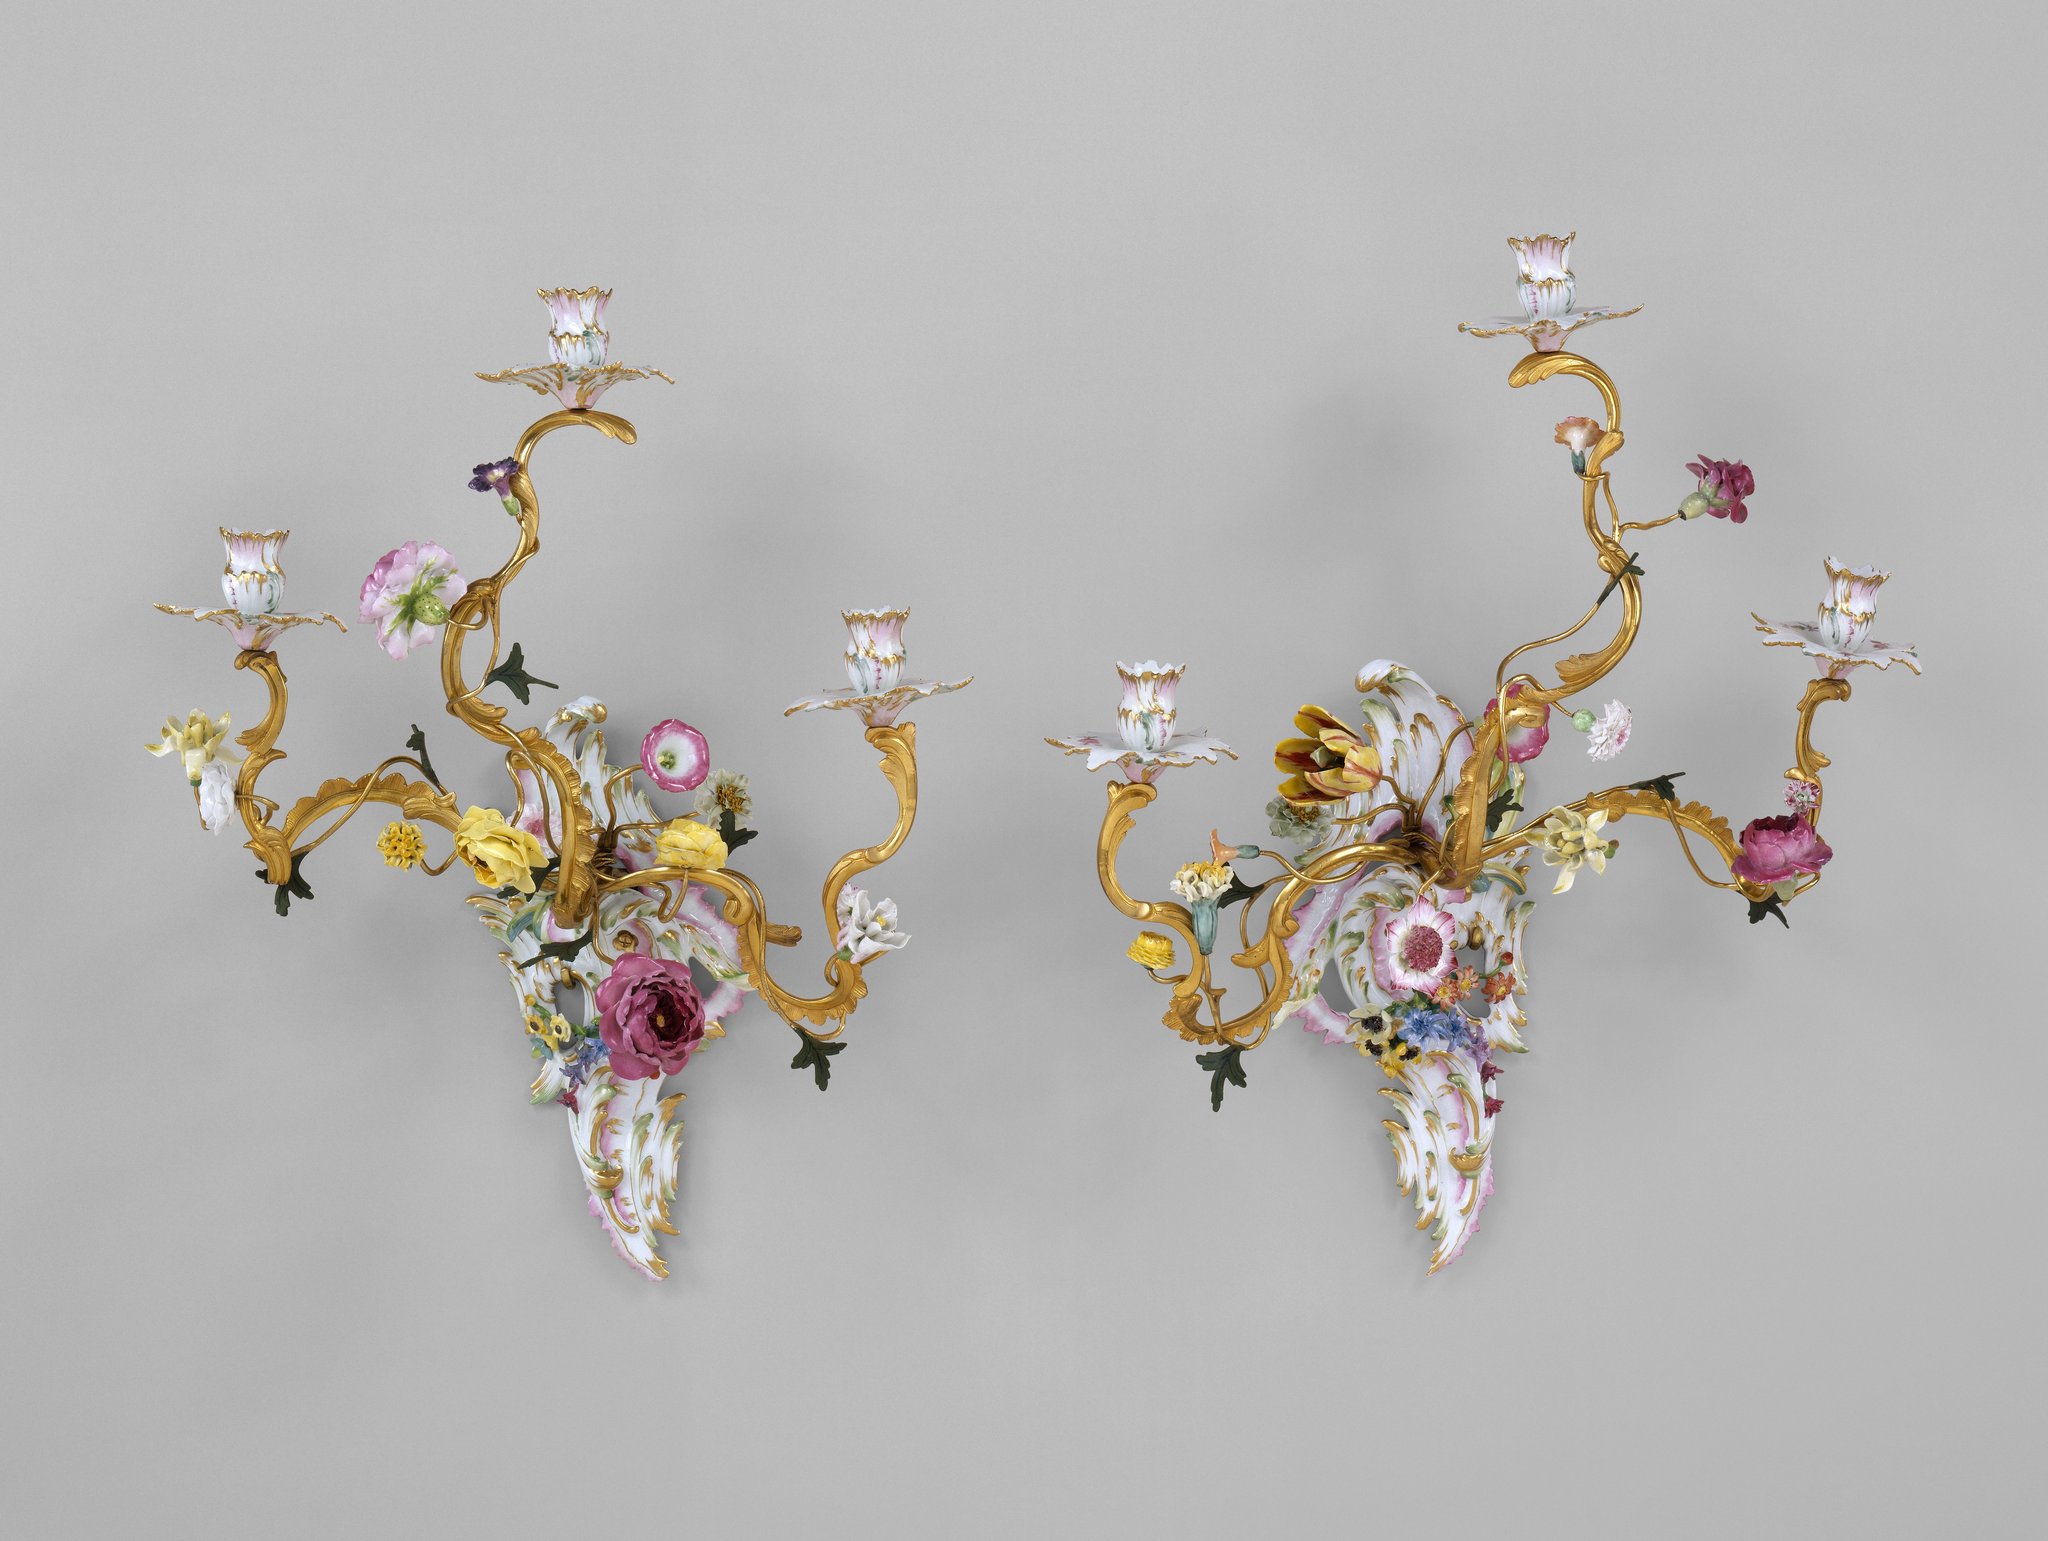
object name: wall light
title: Pair of wall lights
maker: royal porcelain manufactory, berlin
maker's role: manufactory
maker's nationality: german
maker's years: 1763-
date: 1765-1768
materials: brass, gilt bronze, hard paste porcelain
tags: roses